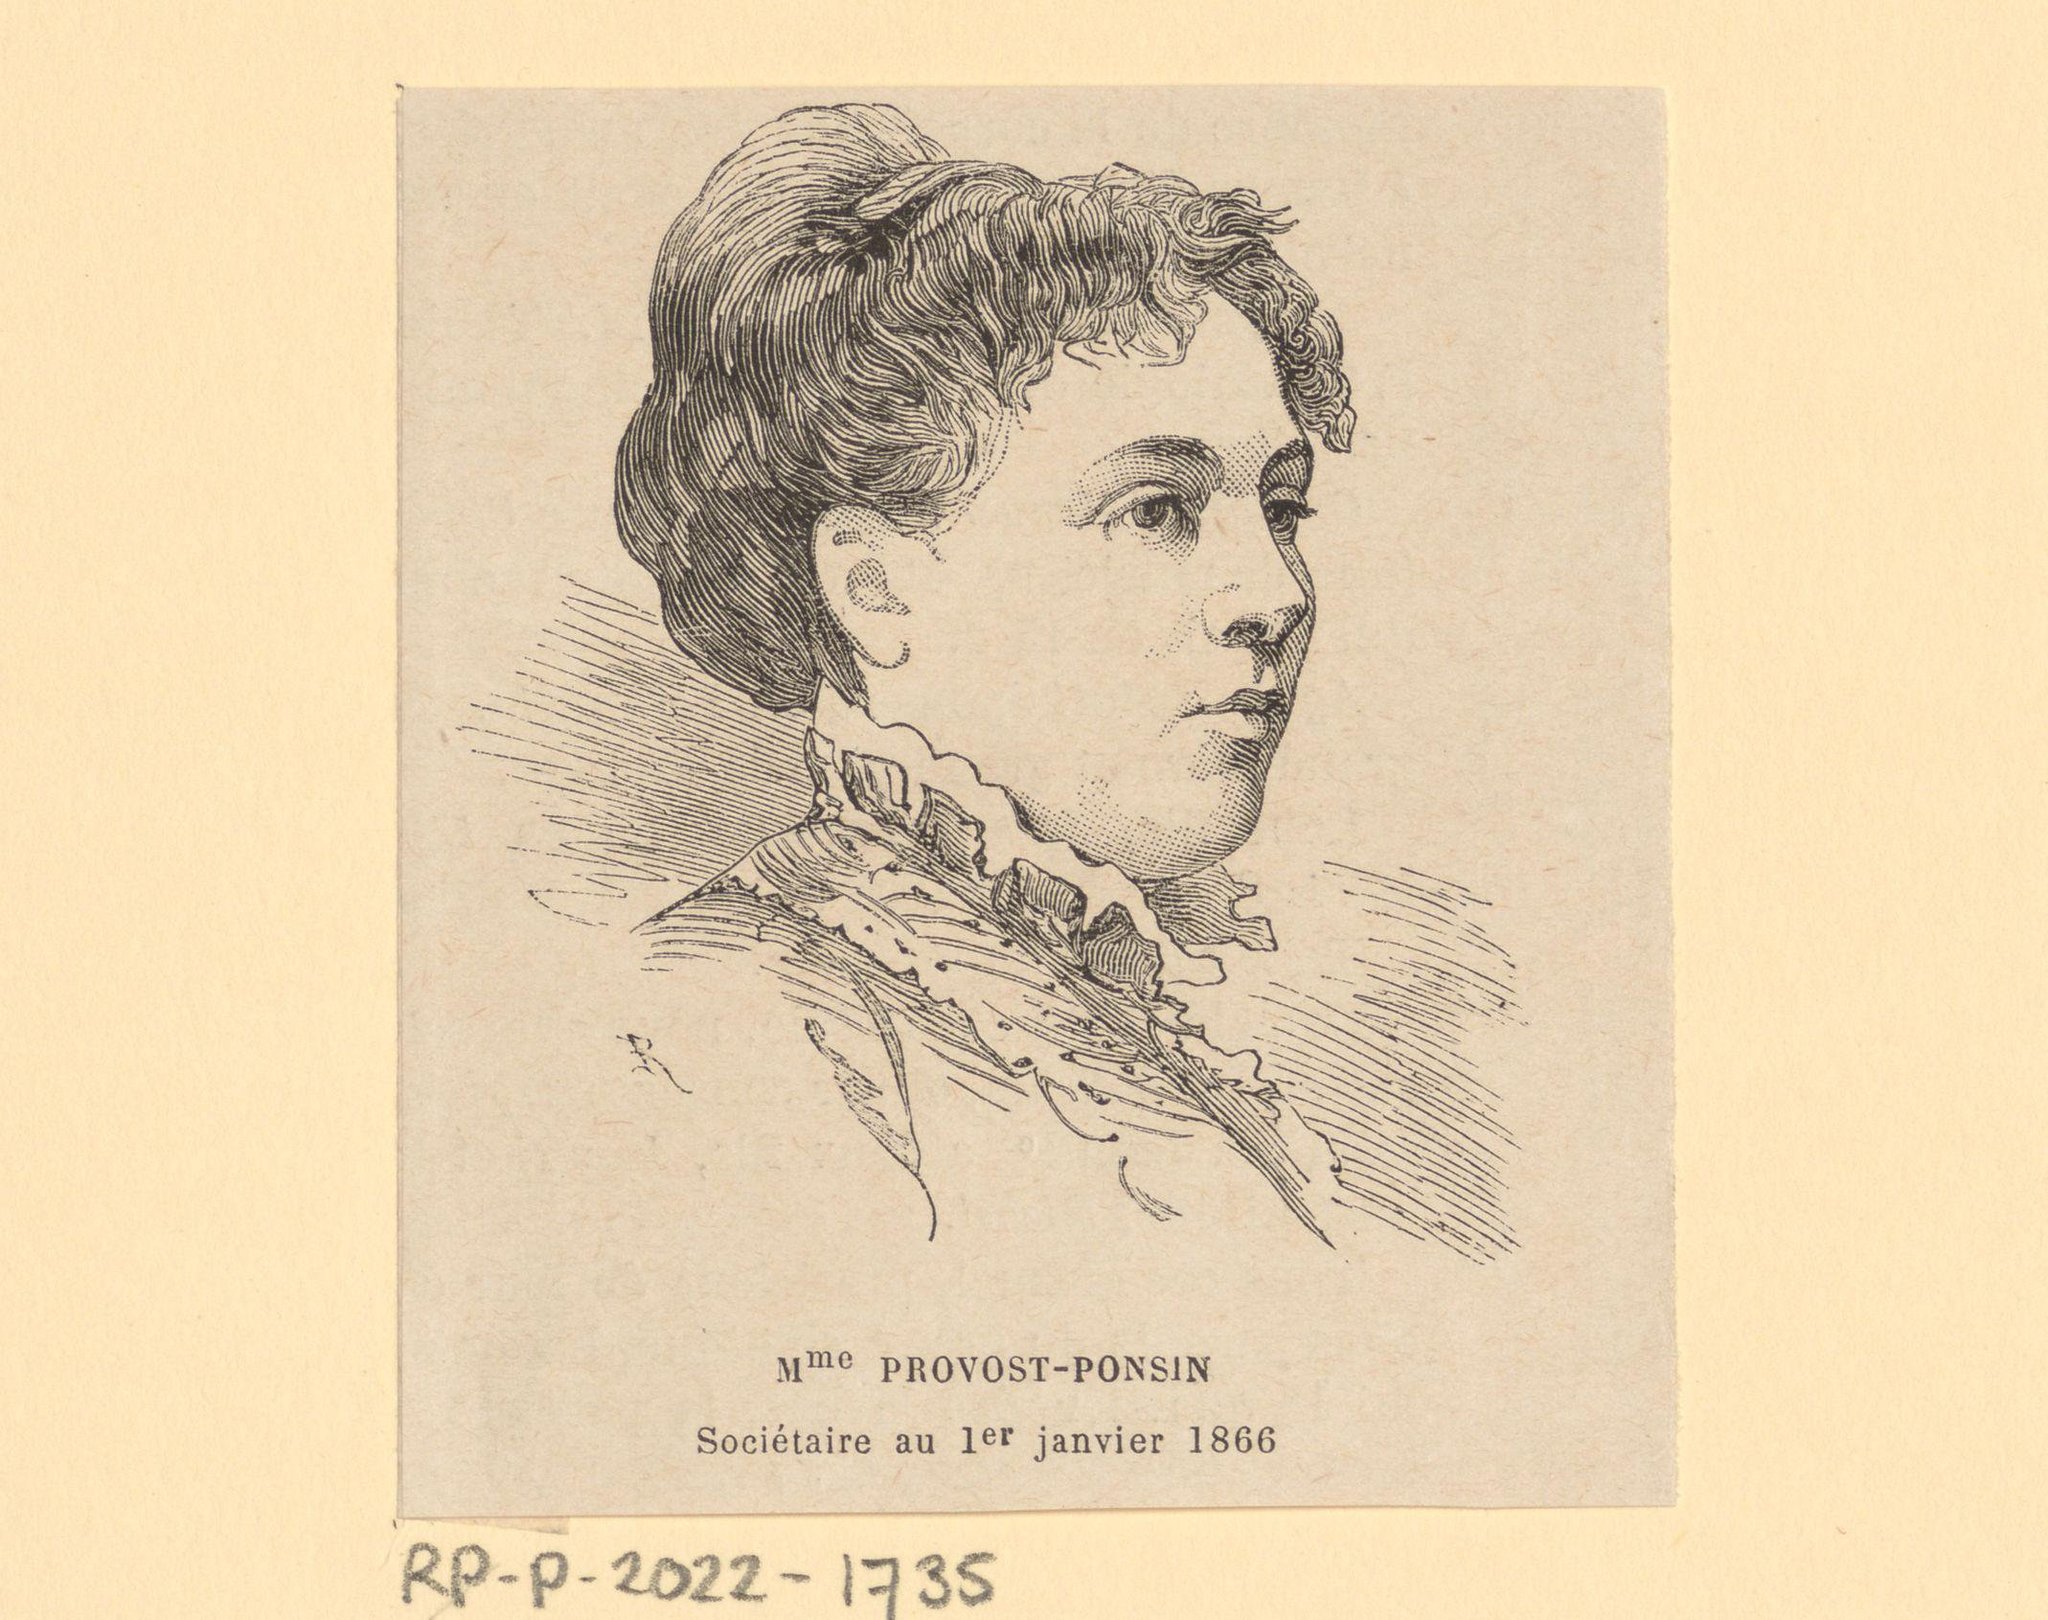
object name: print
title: Mme Provost-Ponsin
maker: Anonymous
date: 1879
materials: paper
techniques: letterpress printing, engraving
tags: historical persons, portrait of actor, actress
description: Prent uit: Le Monde Illustré 23 nr. 1168 (1879), 16 augustus 1879.